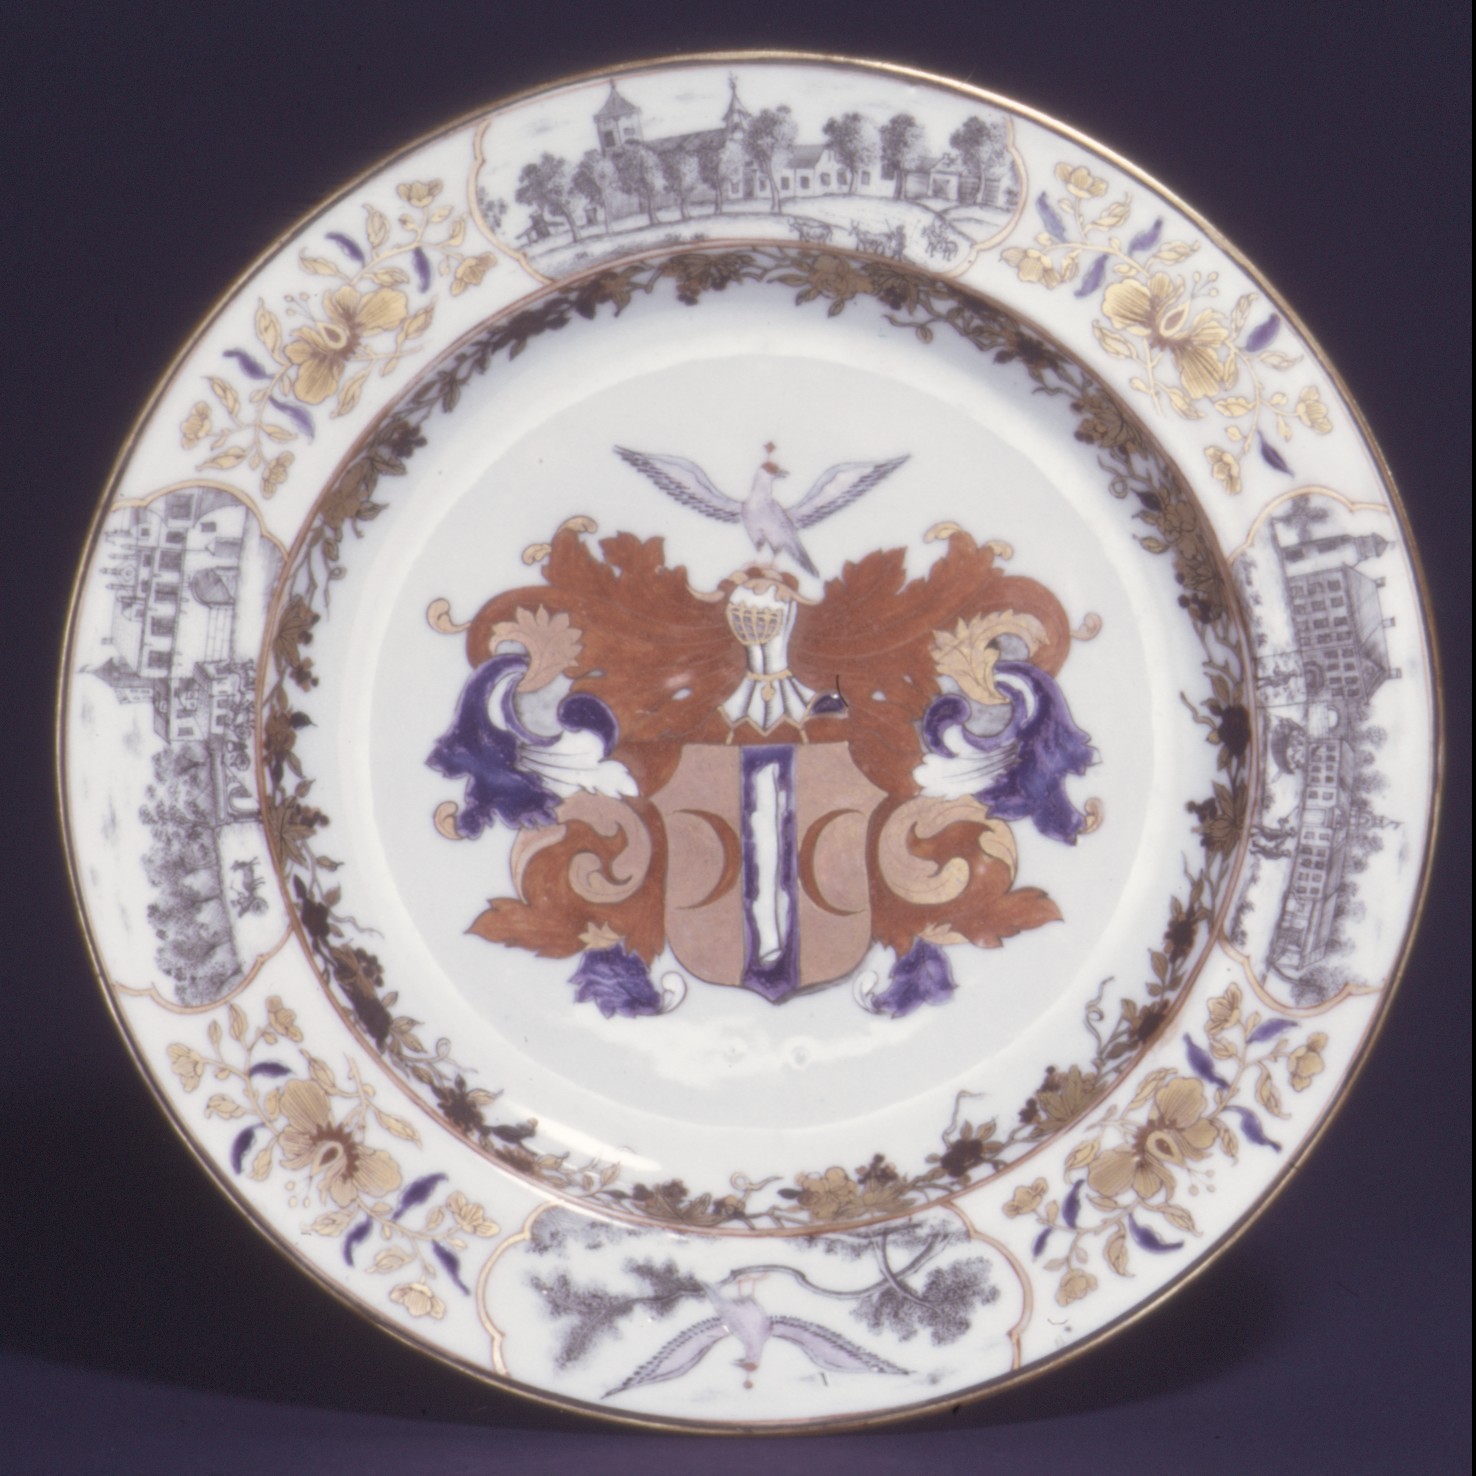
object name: dish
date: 1737-1738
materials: hard paste porcelain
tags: birds,buildings,coat of arms